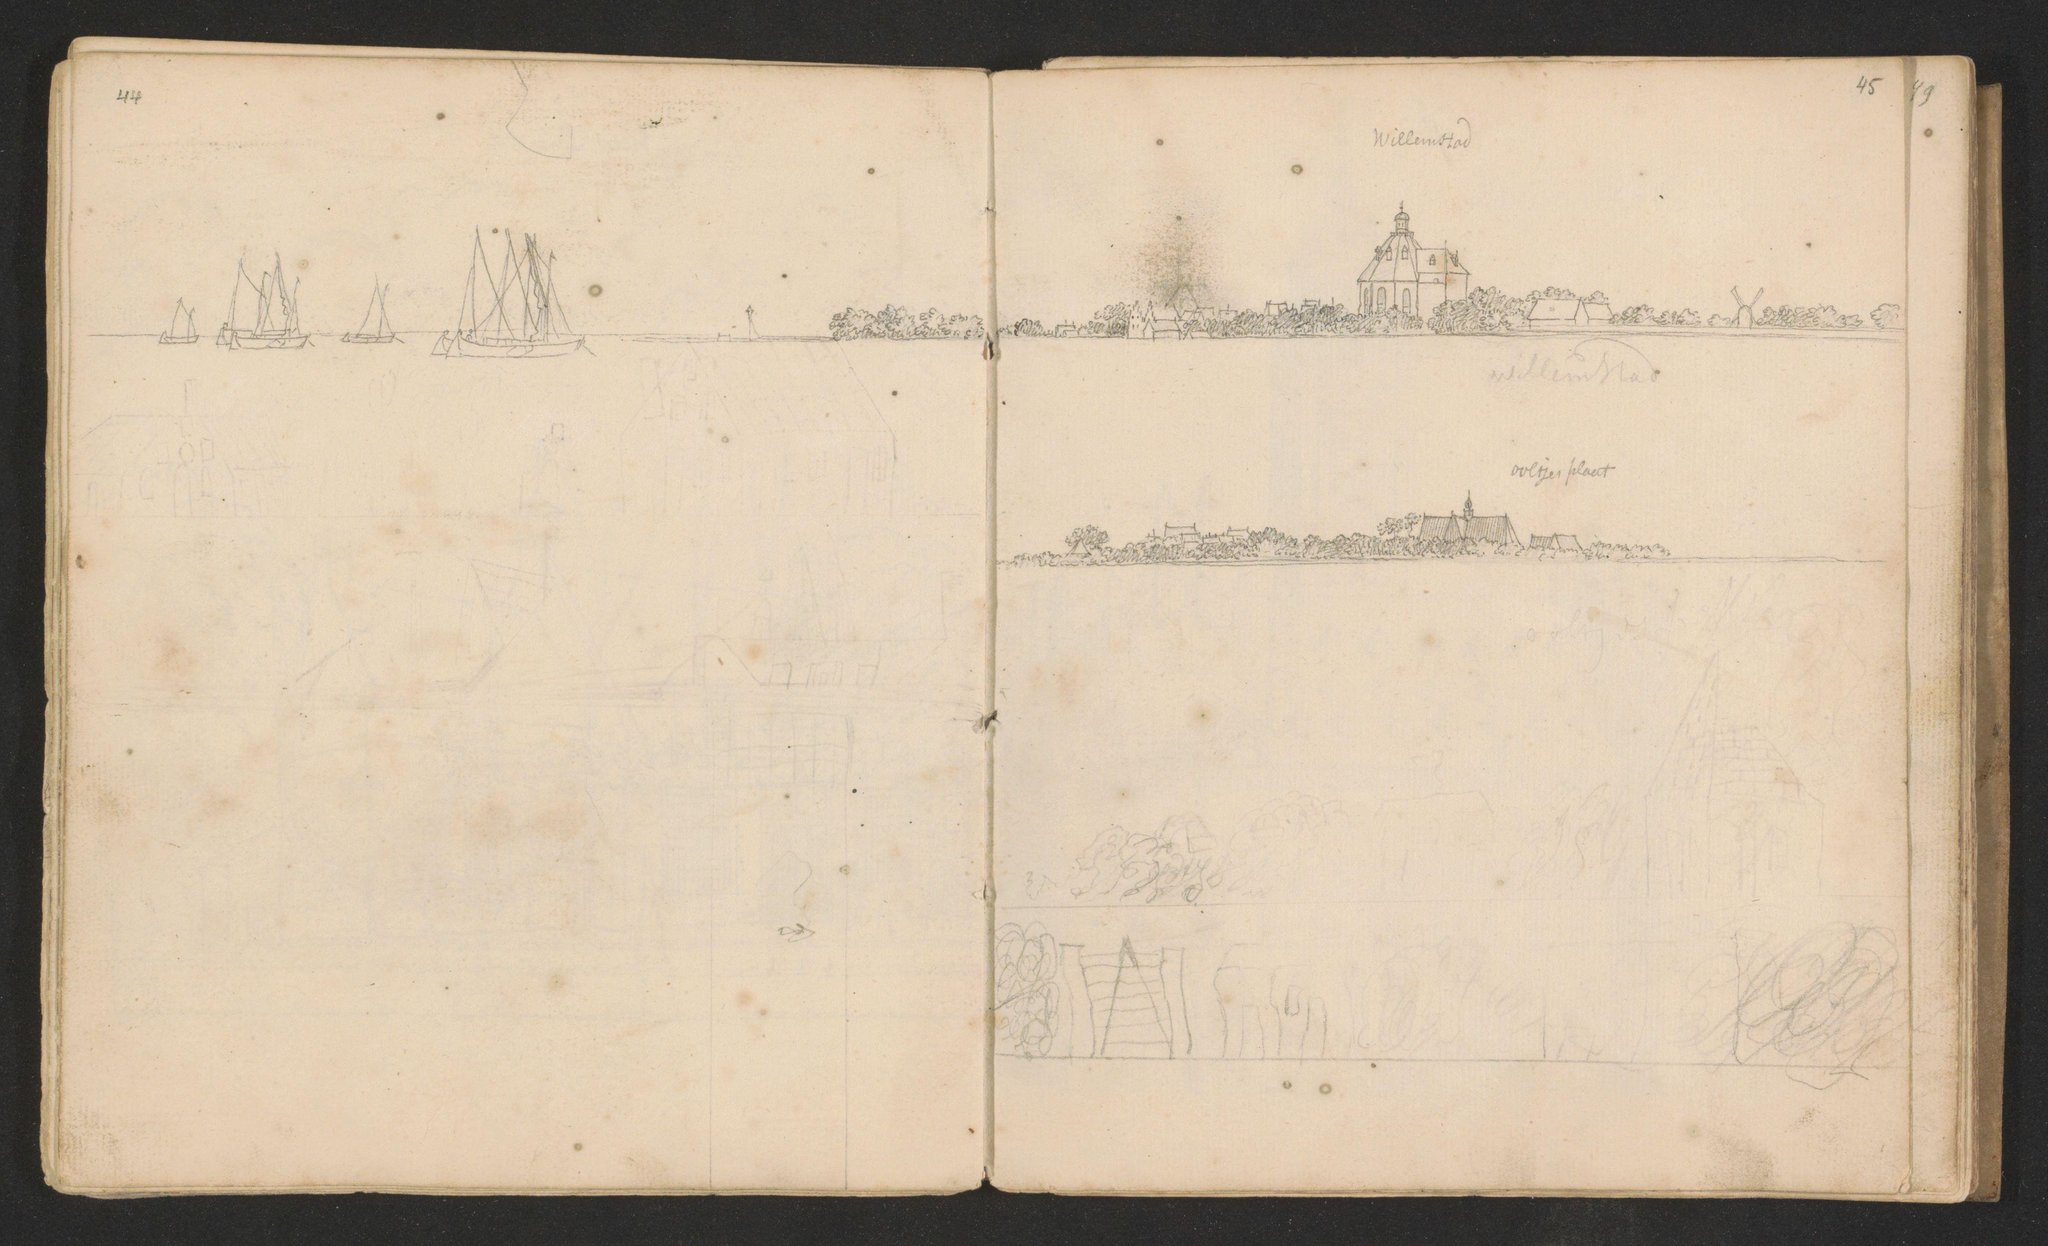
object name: sketchbook leaf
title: Gezichten op Willemstad en Ooltgensplaat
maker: cornelis pronk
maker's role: draughtsman, painter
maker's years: 1691-1759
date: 1728-1732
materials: ink, paper, pencil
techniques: pen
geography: willemstad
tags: prospect of city, town panorama, silhouette of city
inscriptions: annotation: ‘Willemstad/ Ooltjesplaat’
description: Tevens studies van huizen die grotendeels uitgegumd zijn en zeer waarschijnlijk in een andere hand zijn gemaakt. Bladzijde 44 en 45 uit een schetsboek met 96 bladzijden.